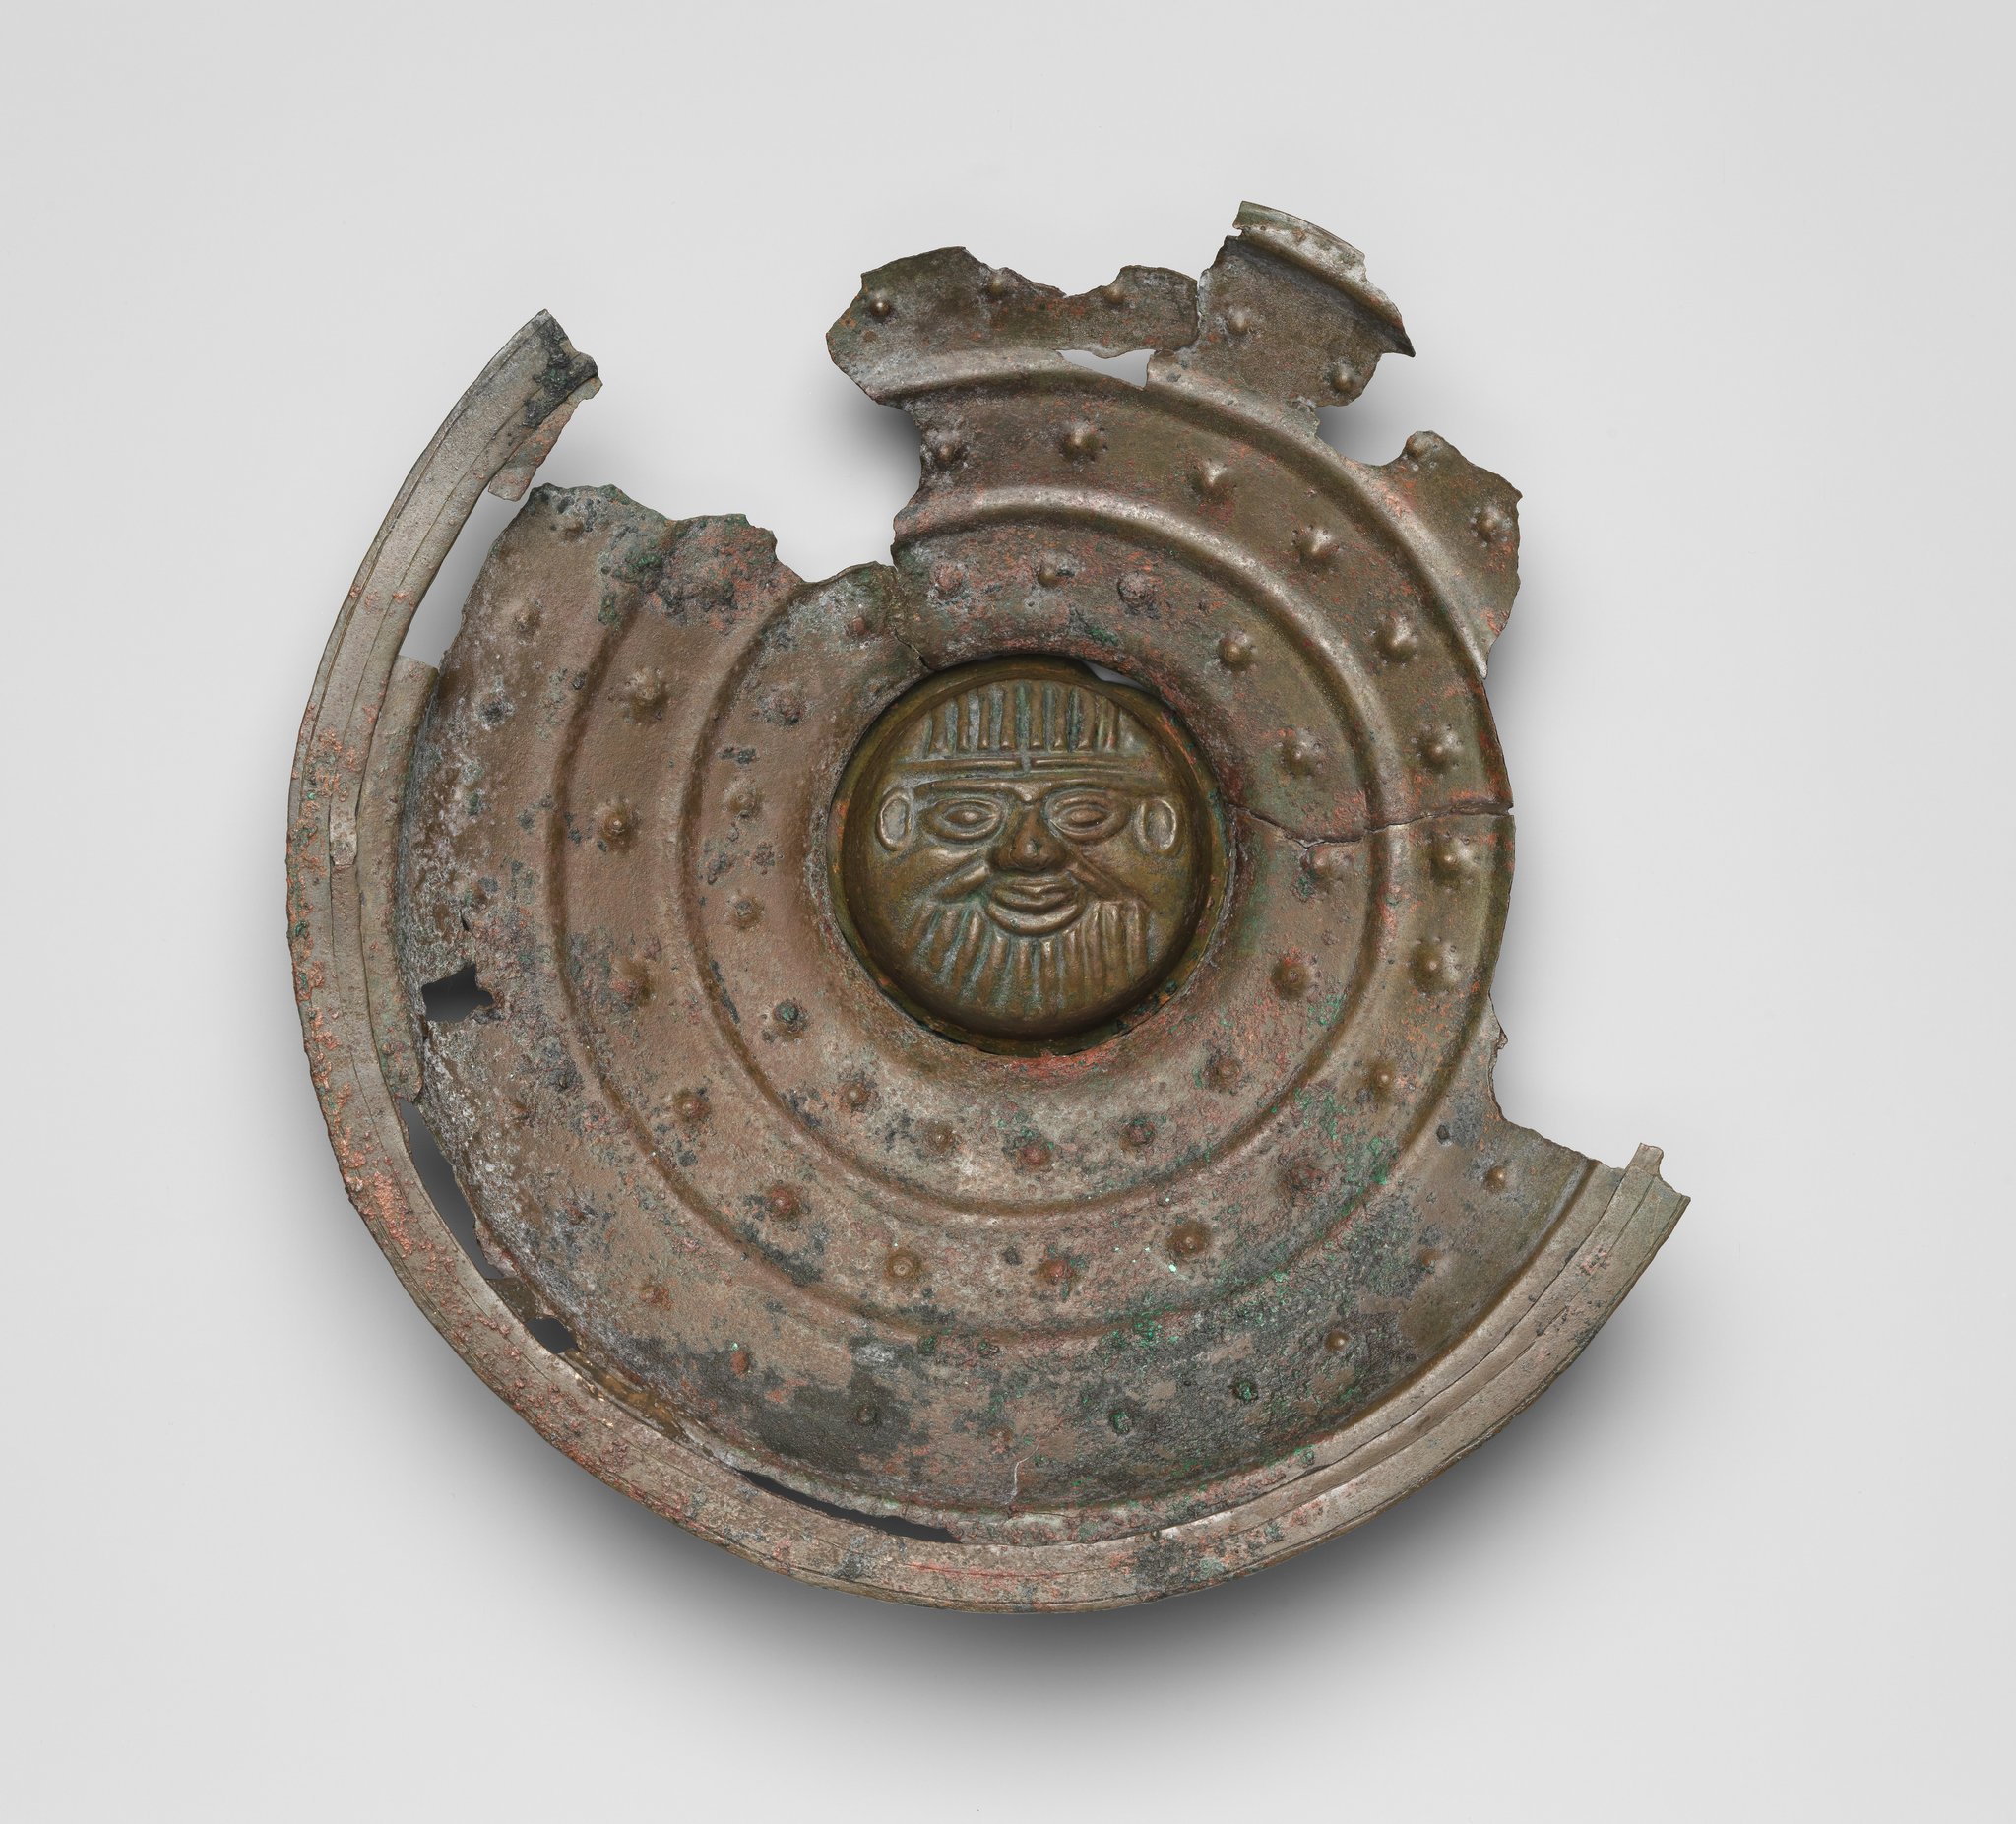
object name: plate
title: Plate (?)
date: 700-601 BCE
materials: bronze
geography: iran